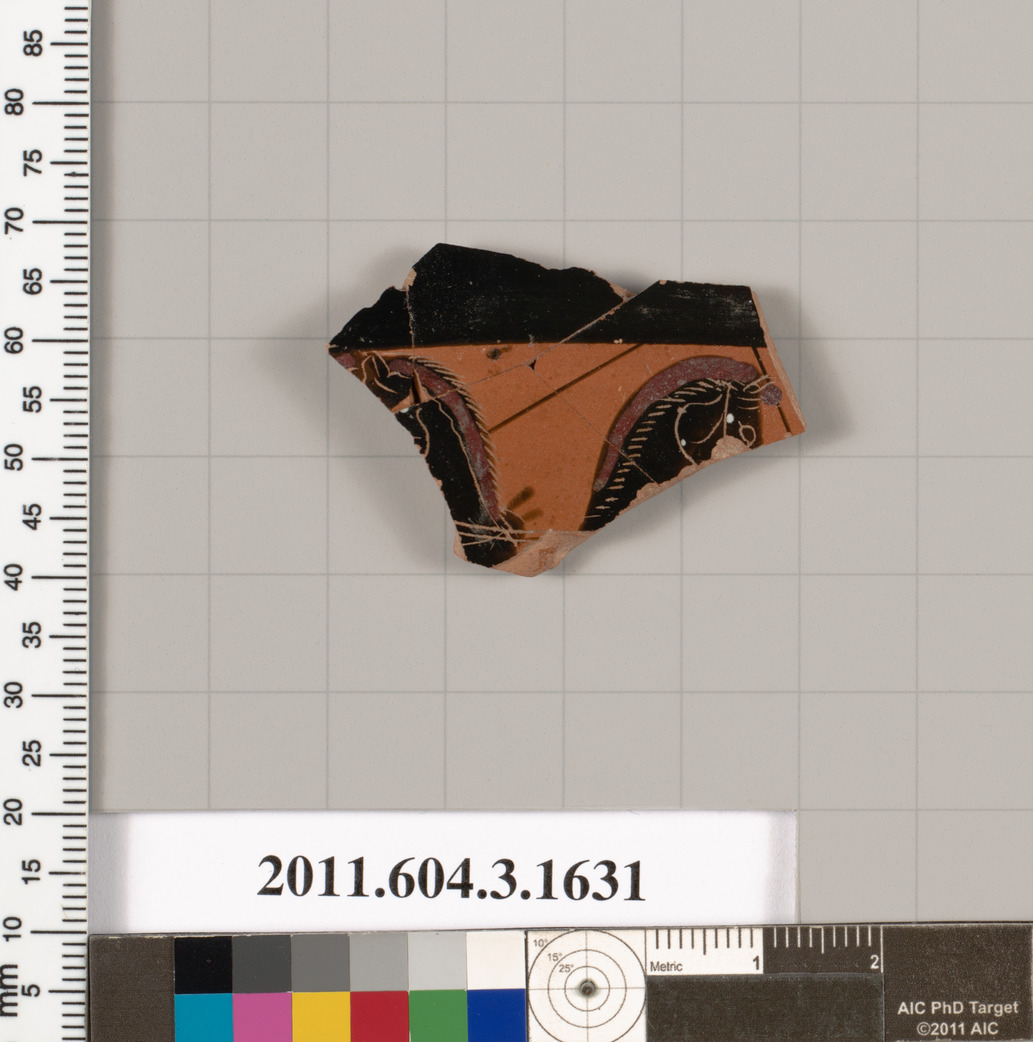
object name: kylix fragment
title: Terracotta fragment of a kylix: Band cup (drinking cup)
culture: greek, attic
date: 567-535 BCE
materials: terracotta